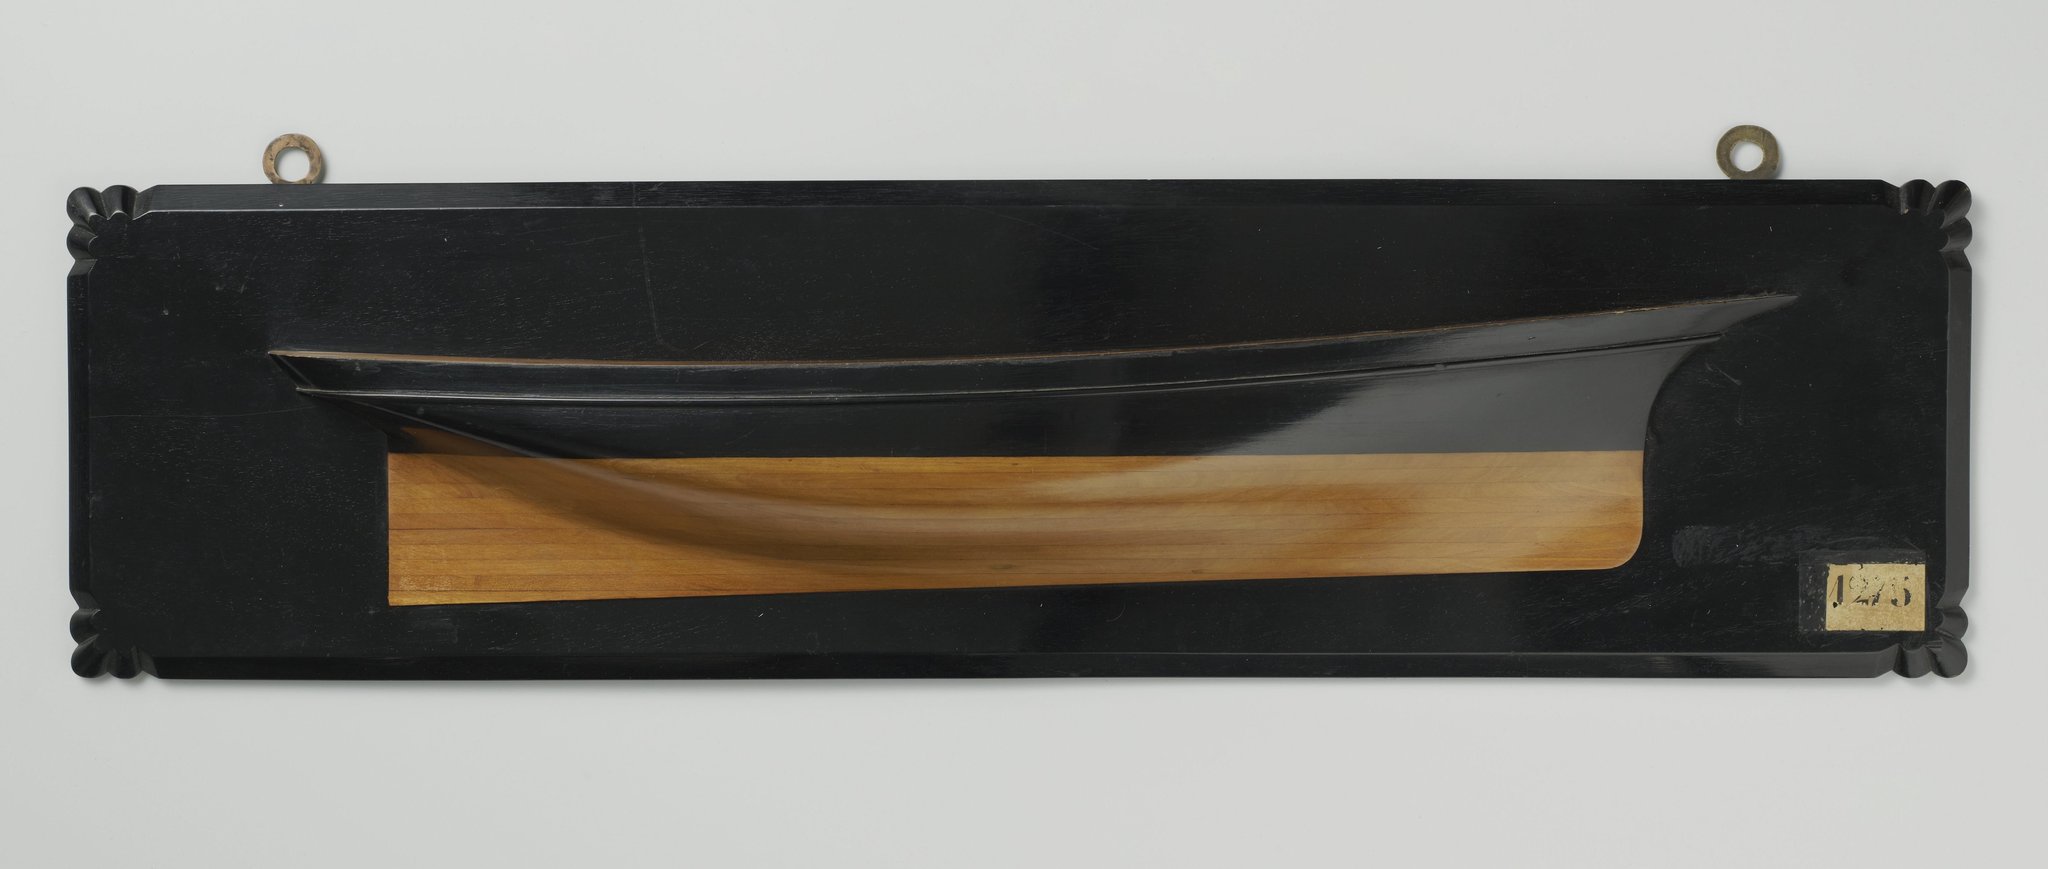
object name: ship model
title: Half model of a pilot schooner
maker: jan smit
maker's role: ship modeller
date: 1874-1875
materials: wood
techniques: polychromy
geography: slikkerveer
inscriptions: label, bottom right: ‘1275’ former inventory label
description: Stapelmodel (stuurboord) van een schoener. Zeer scherpe klippersteven. Overhangend hek; geen roer. De zeeg loopt naar voren op, een reehout. V-vormig onderwaterschip. Geen tuig.